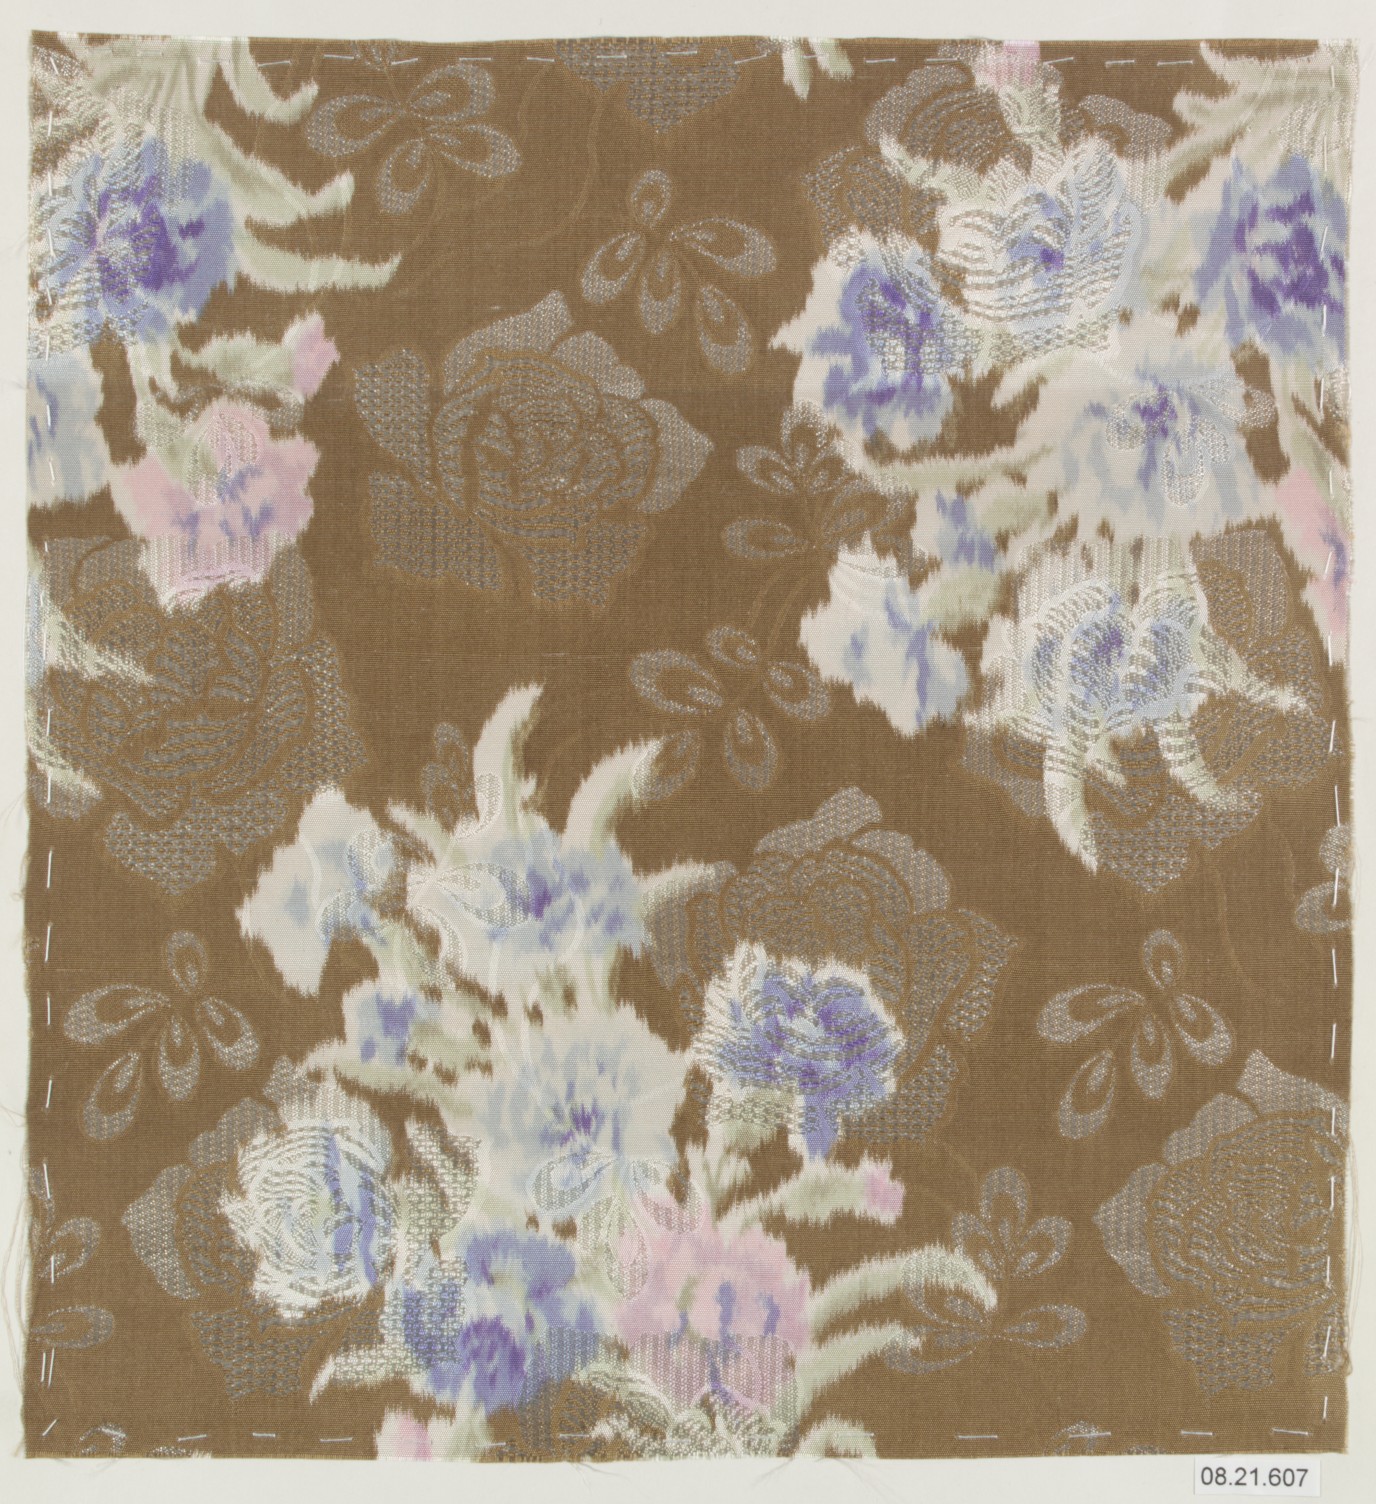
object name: textile sample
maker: Anonymous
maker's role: designer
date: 1900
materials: silk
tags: flowers